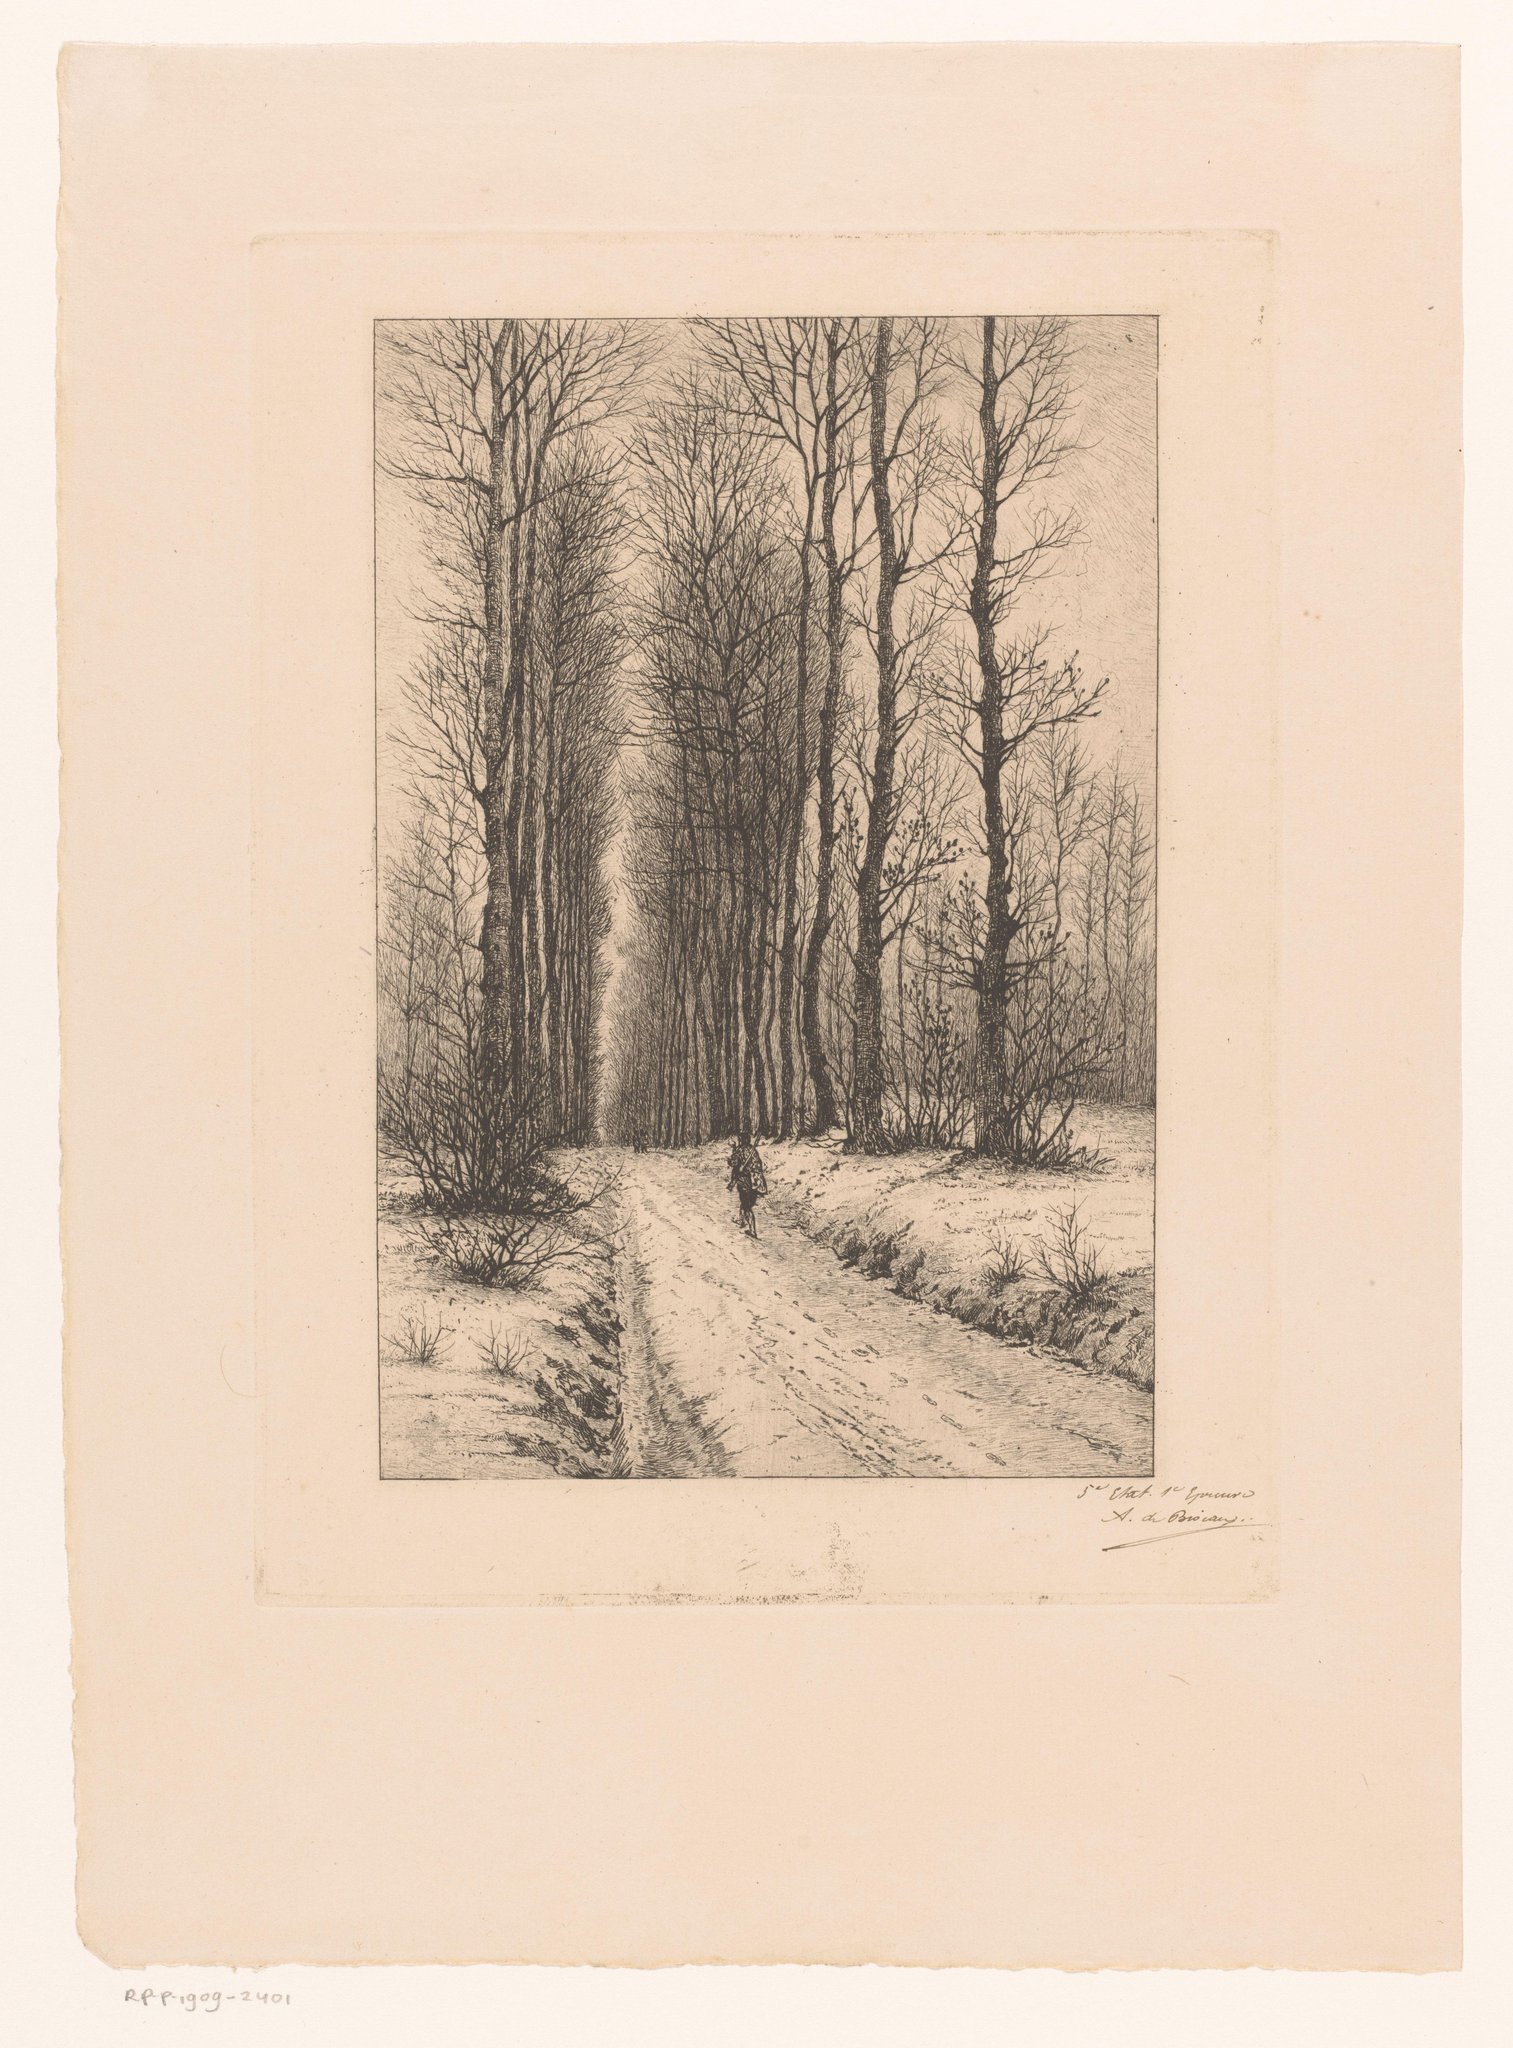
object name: print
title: Besneeuwd bospad met jager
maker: aristide de biseau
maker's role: print maker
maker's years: 1844-1883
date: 1854-1883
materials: paper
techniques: drypoint, etching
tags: hunter, forest, wood, winter landscape; landscape symbolizing winter (the four seasons of the year), snow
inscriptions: inscription: ‘5e Etat 1e Epreuve’, collector's mark: Lugt 2228